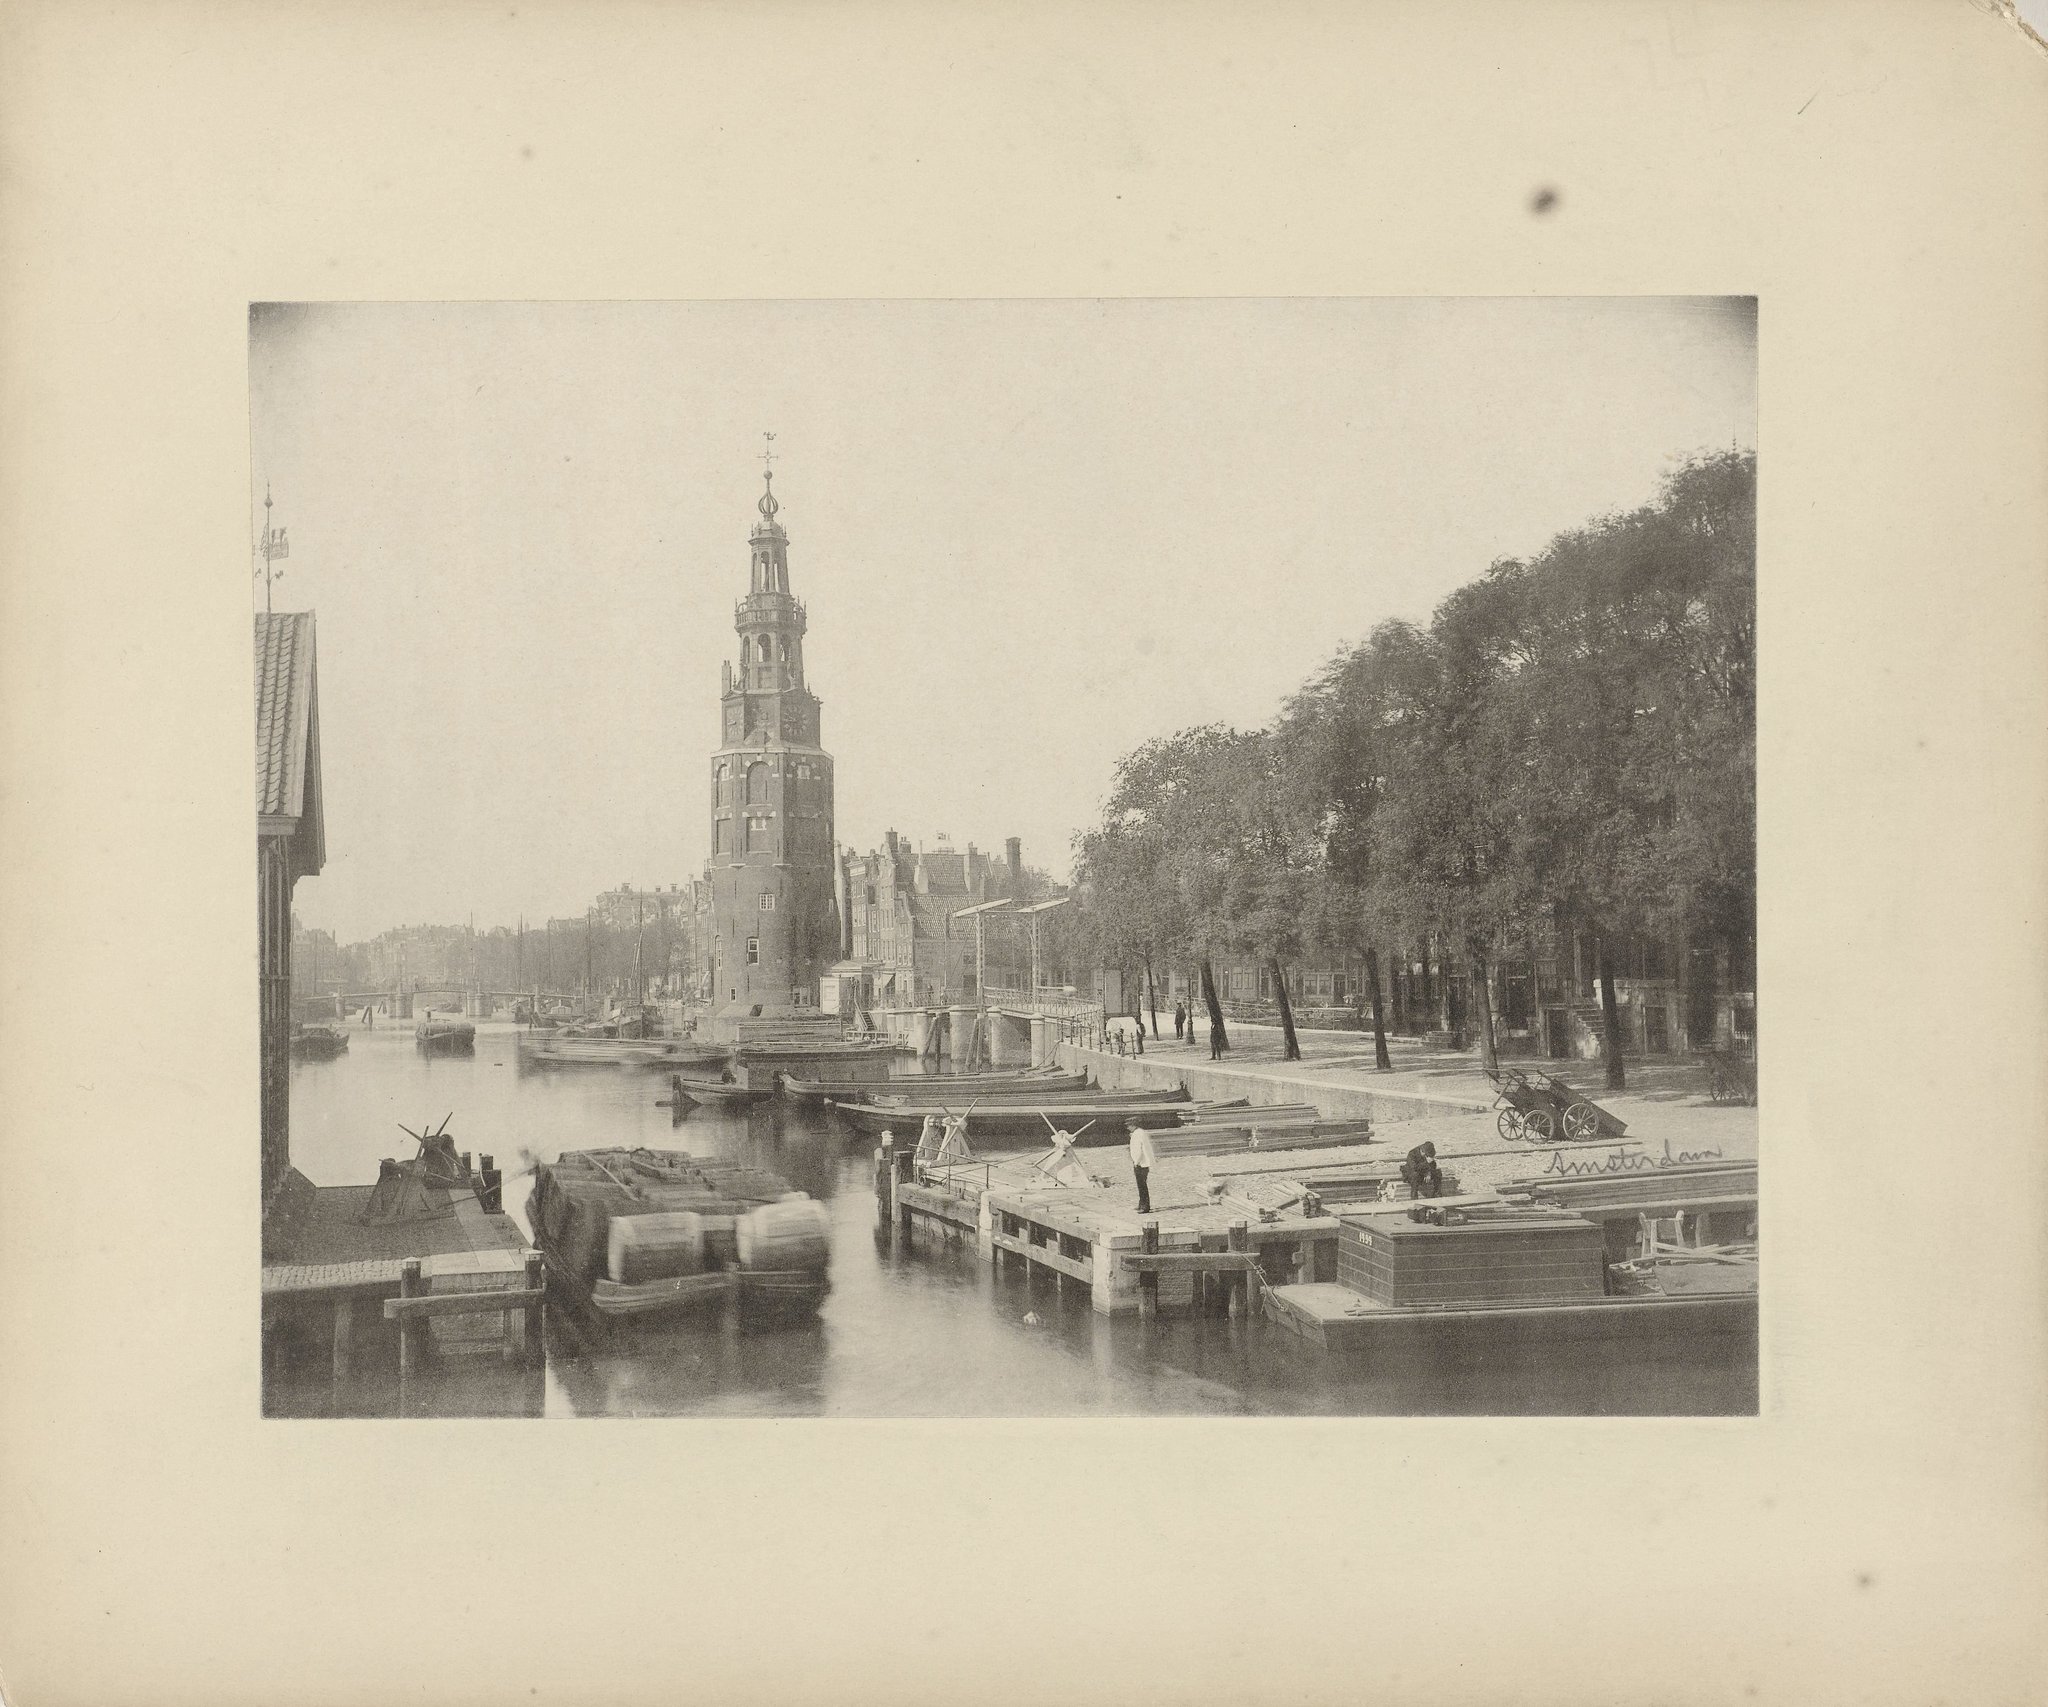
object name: photograph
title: Gezicht op de Montelbaanstoren in Amsterdam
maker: Anonymous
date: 1890-1910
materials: cardboard, paper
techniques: photograph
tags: tower (of house or building), amsterdam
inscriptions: inscription: ‘geschonken door de historical society of western pennsylvania, Pittsburgh’